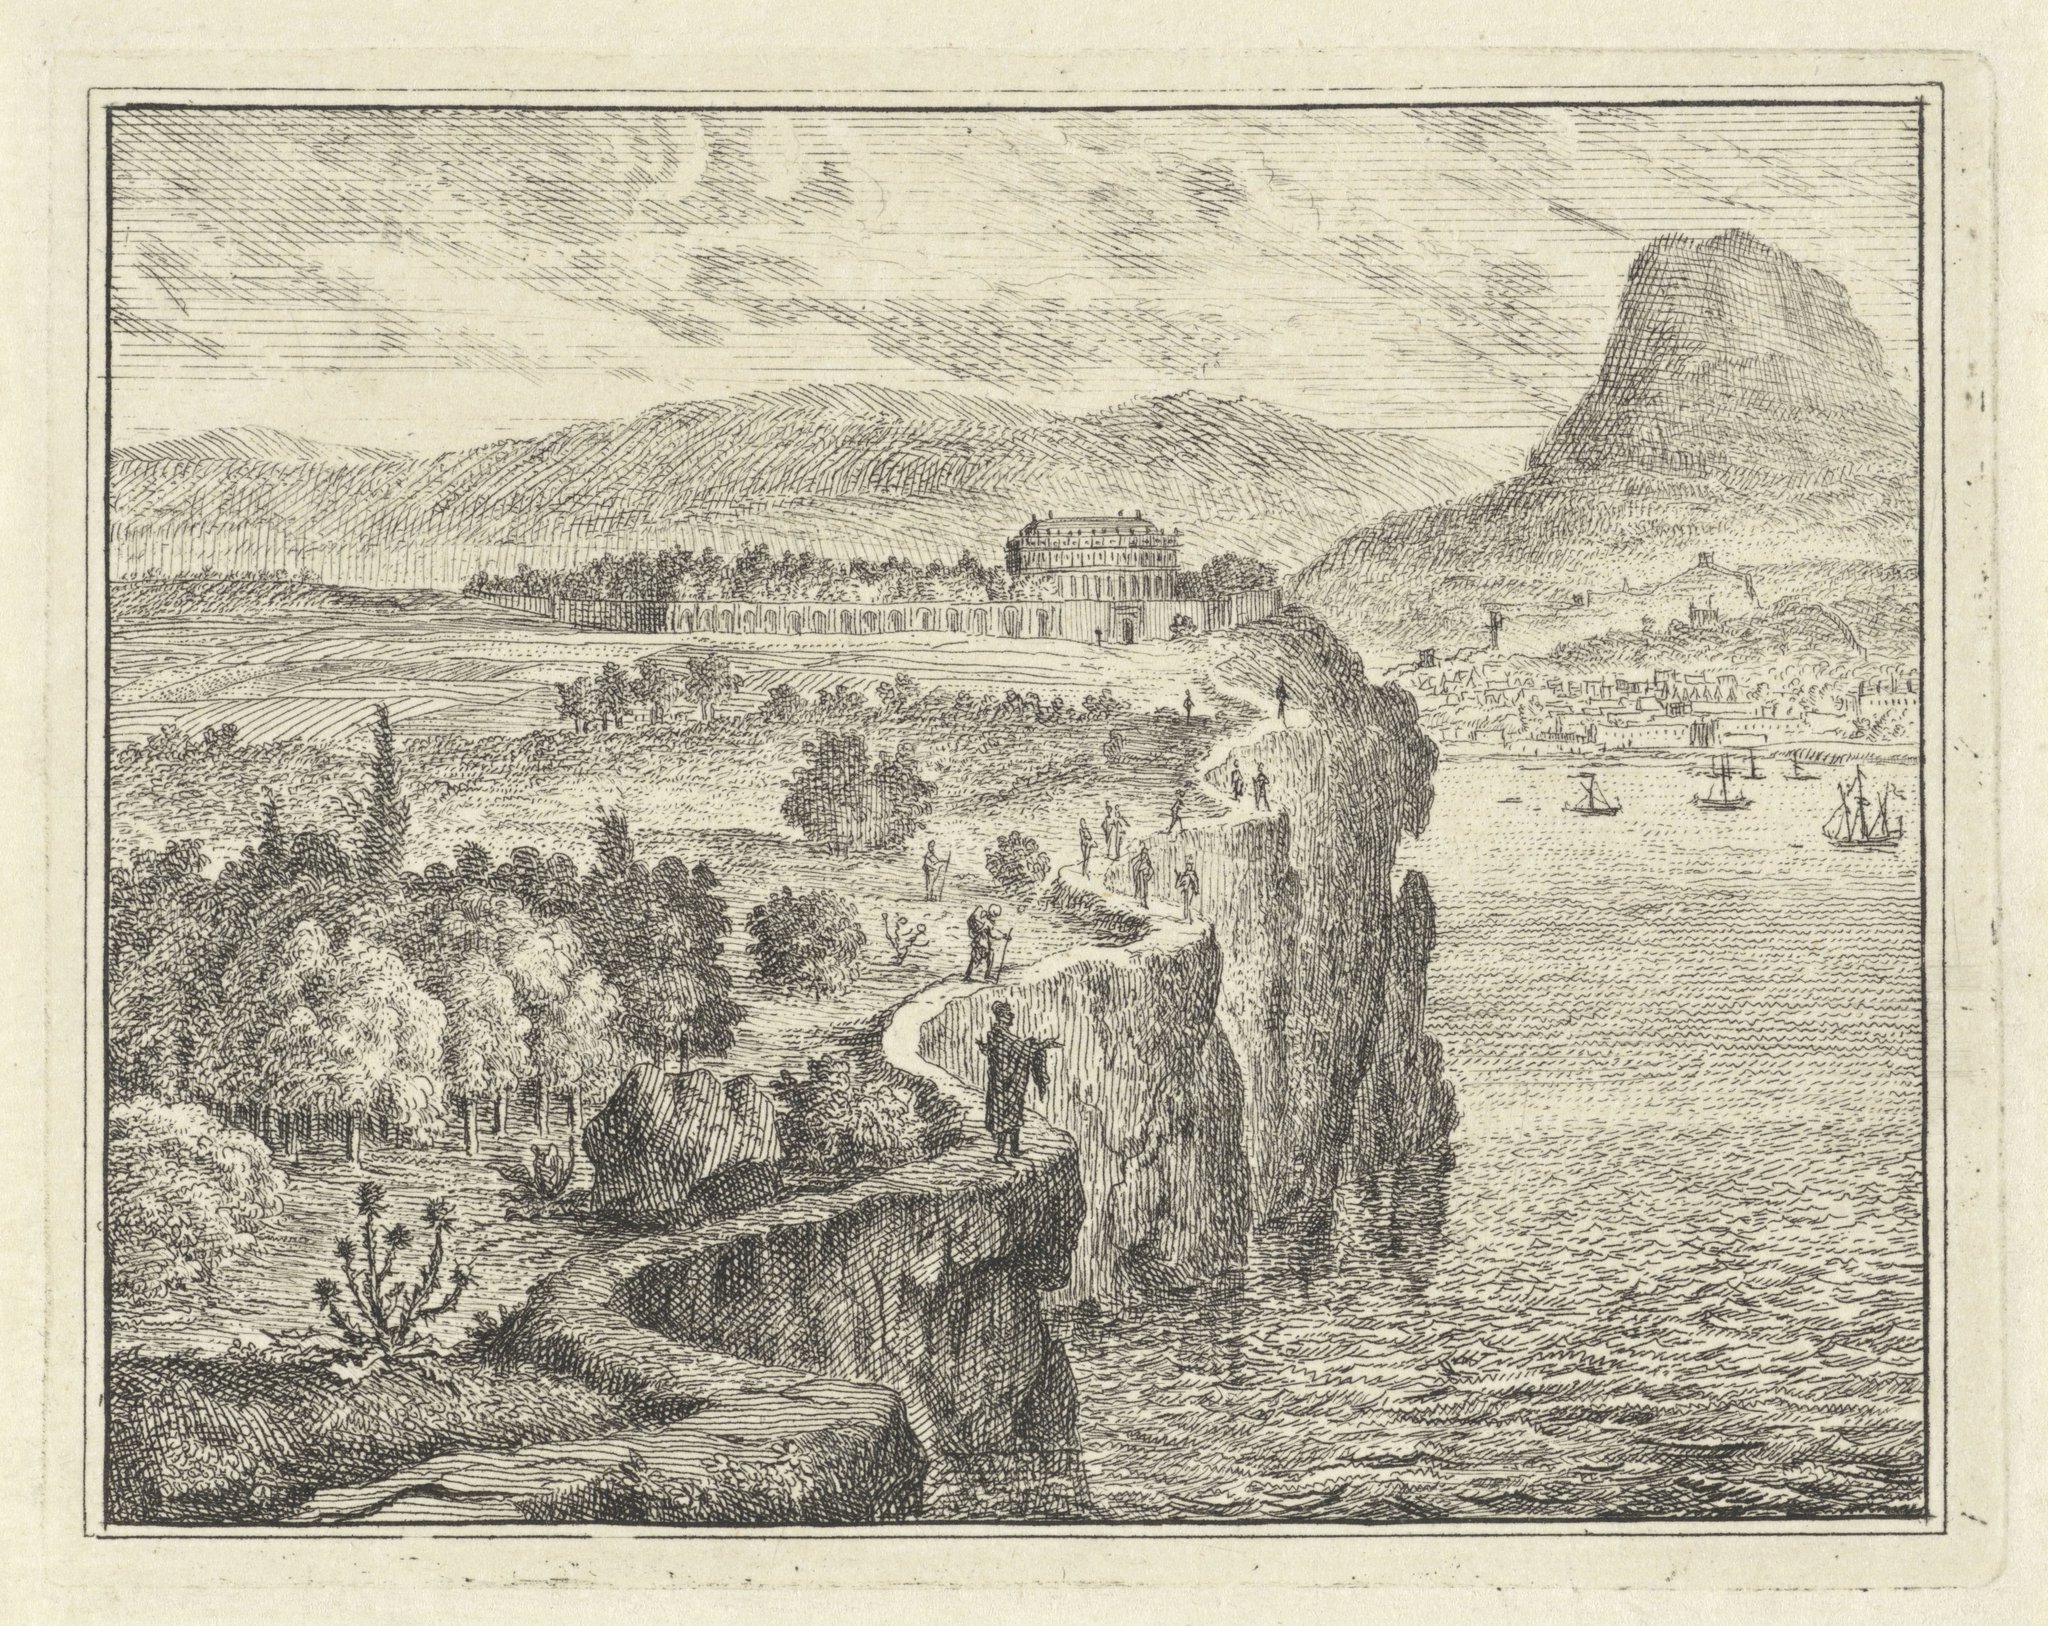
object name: print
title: Pad langs kliffen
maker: vincent laurensz. van der vinne (ii)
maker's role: draughtsman, print maker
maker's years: 1686-1742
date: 1714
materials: paper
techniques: etching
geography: haarlem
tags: road, path, coastal cliff or crag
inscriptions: collector's mark: Lugt 240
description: Prent oorspronkelijk bedoeld als boekillustratie voor: Spinniker, Adriaan. Leerzaame zinnebeelden. Haarlem: [boekverkoper] Isaak van der Vinne (I) en Amsterdam: [drukker] Johannes Krelius, 1714. Later gebruikt als boekillustratie in: Spinniker, Adriaan. Vervolg der leerzaame zinnebeelden, : spiegel der boetvaardigheid en genade en eenige Stichtelyke gezangen. Haarlem: Jan Bosch, 1758.